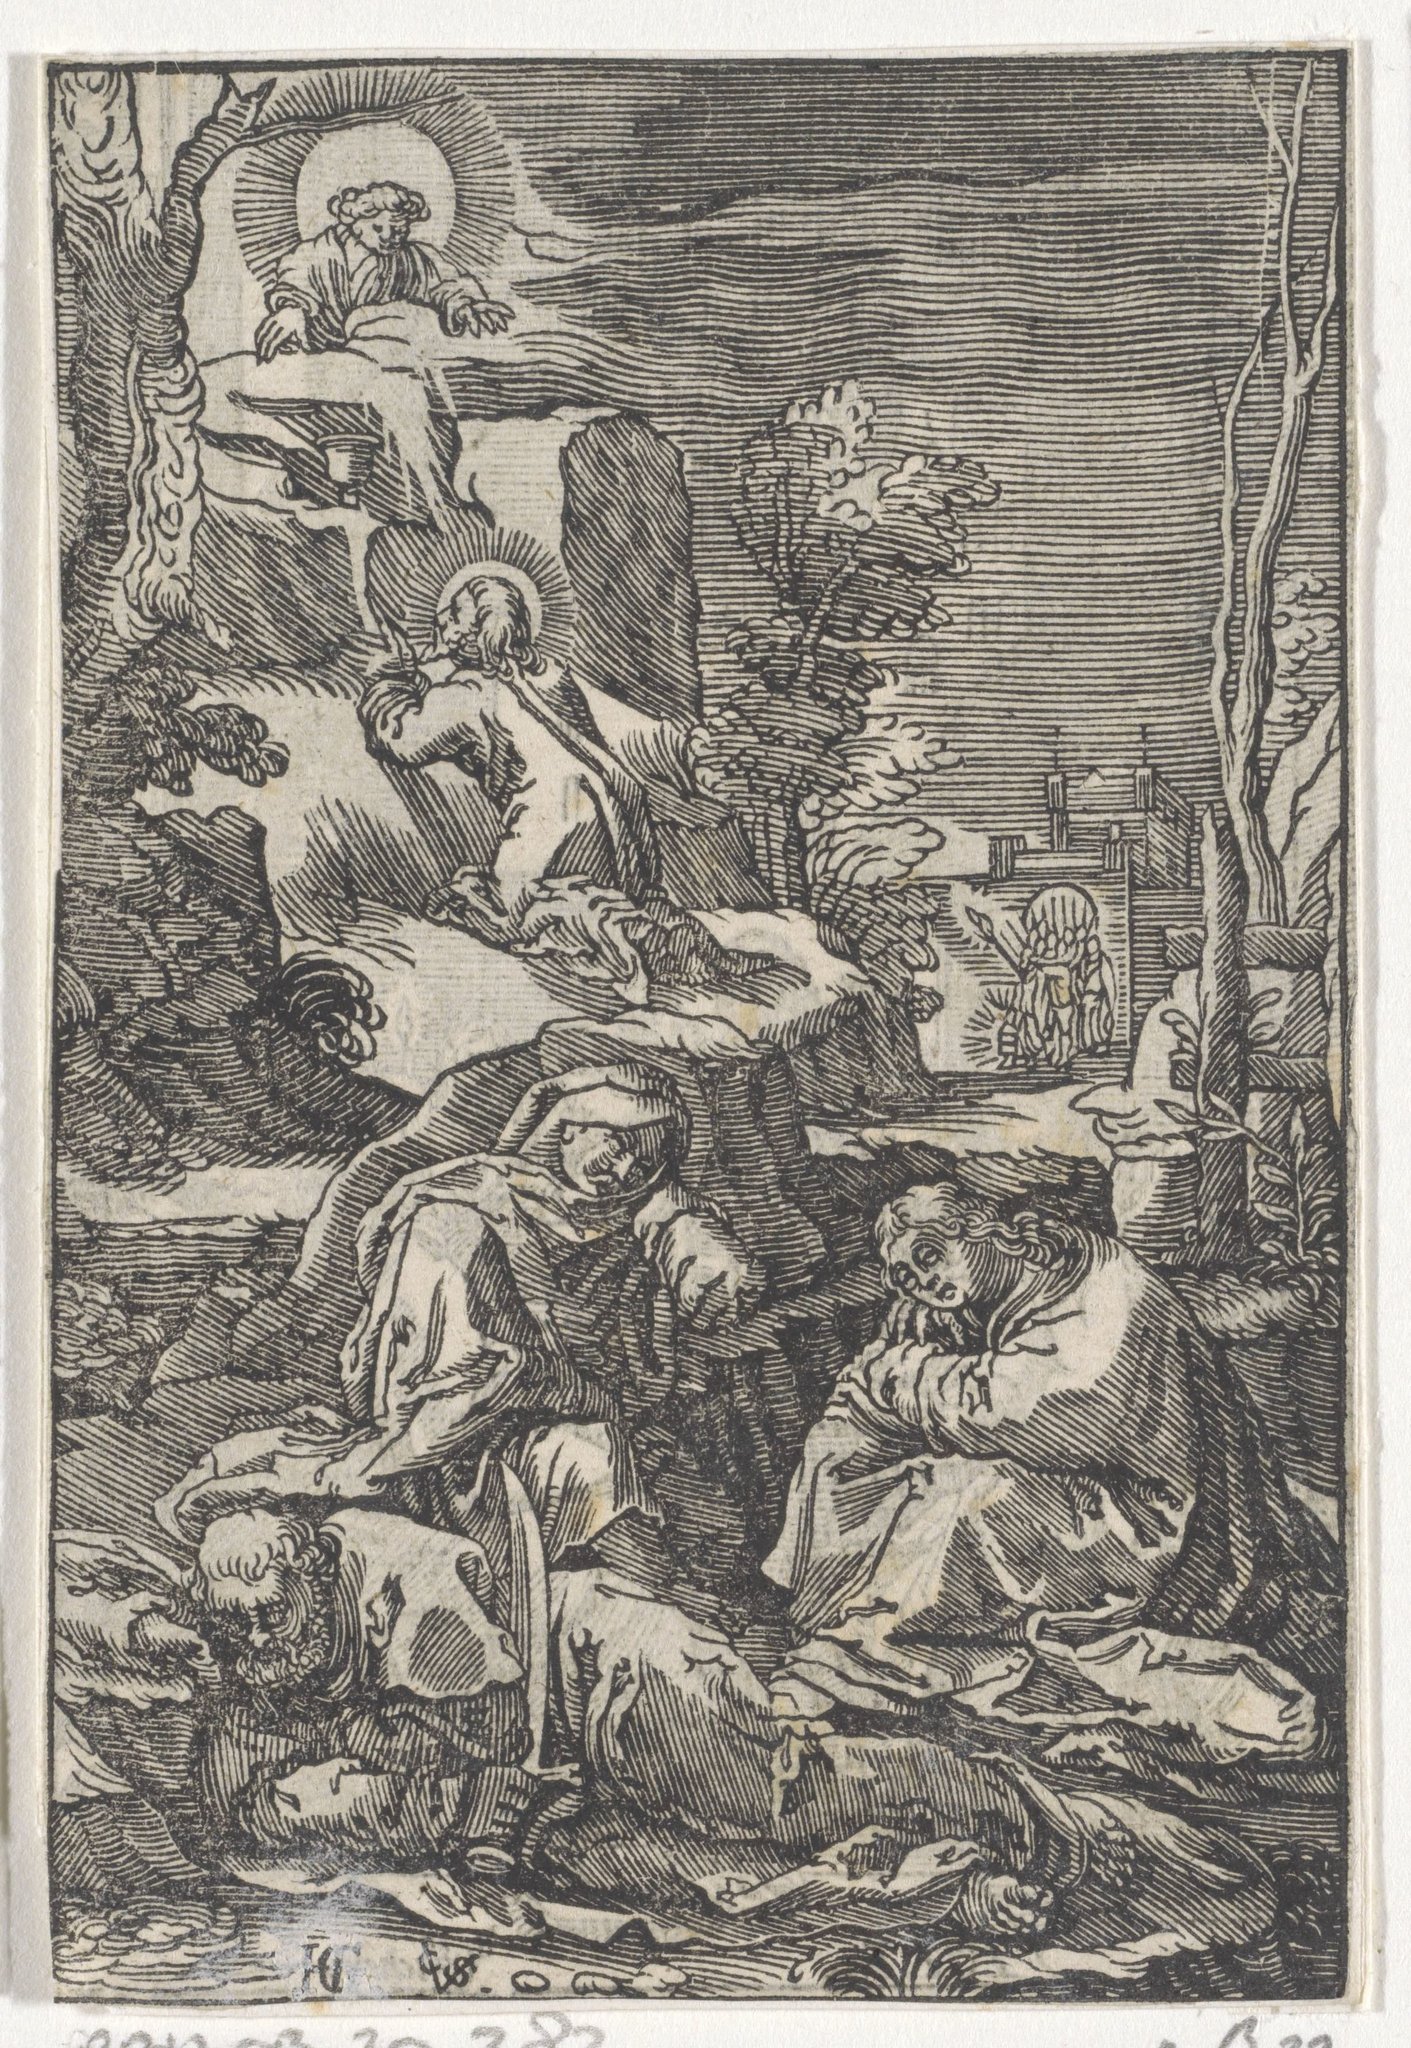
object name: book illustration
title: Christus in de hof van Getsemane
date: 1648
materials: paper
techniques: woodcut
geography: amsterdam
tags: agony of christ; three (or eleven) apostles sleeping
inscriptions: collector's mark: Lugt 240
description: Prent uit: Sichem, Christoffel van (II). 'tSchat der zielen, dat is: Het geheele leven ons Heeren Iesu Christi. Amsterdam: Pieter Jacobsz. Paets, 1648. Prent uit: Biblia sacra dat is De geheele Heylighe Schrifture bedeylt in 't Out en Nieu Testament. Amsterdam: Pieter Jacobsz. Paets, 1657.